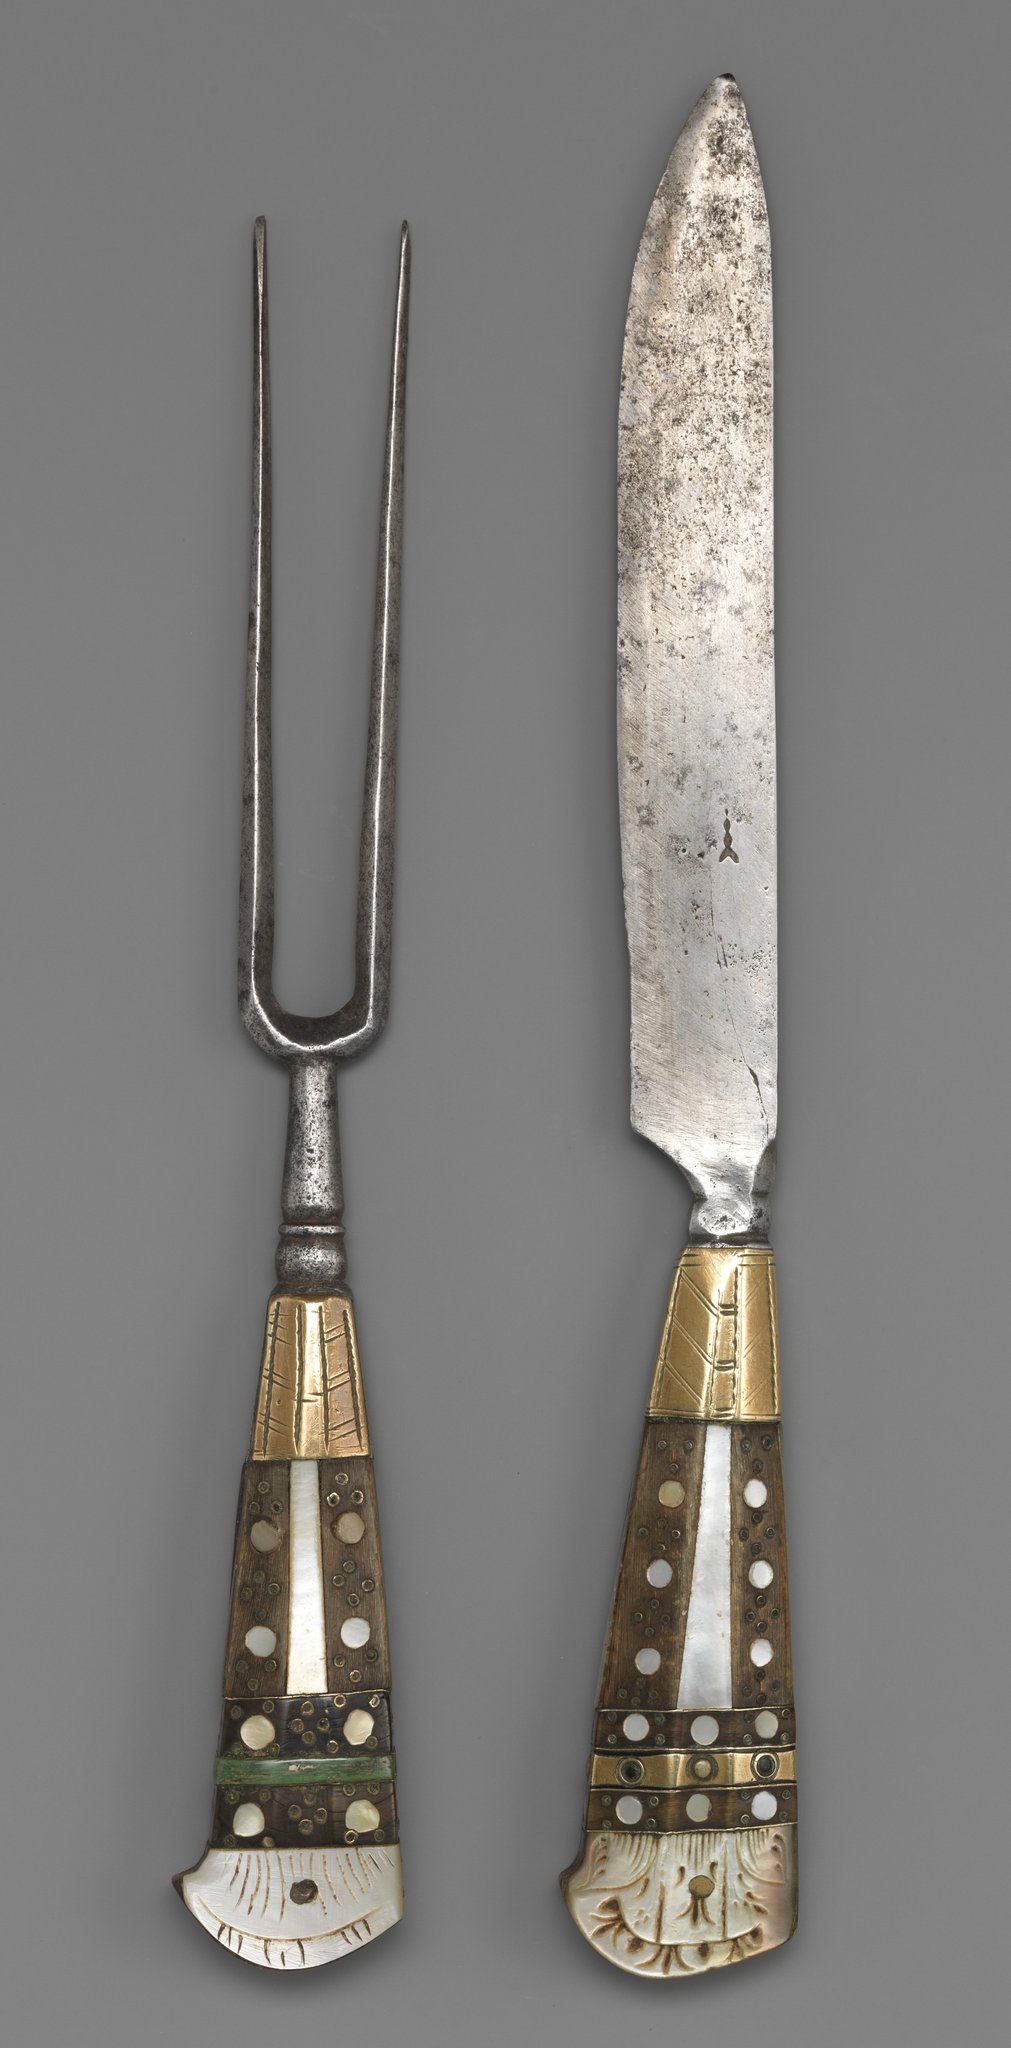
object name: table knife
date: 1701-1800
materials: metal, mother of pearl, steel, wood